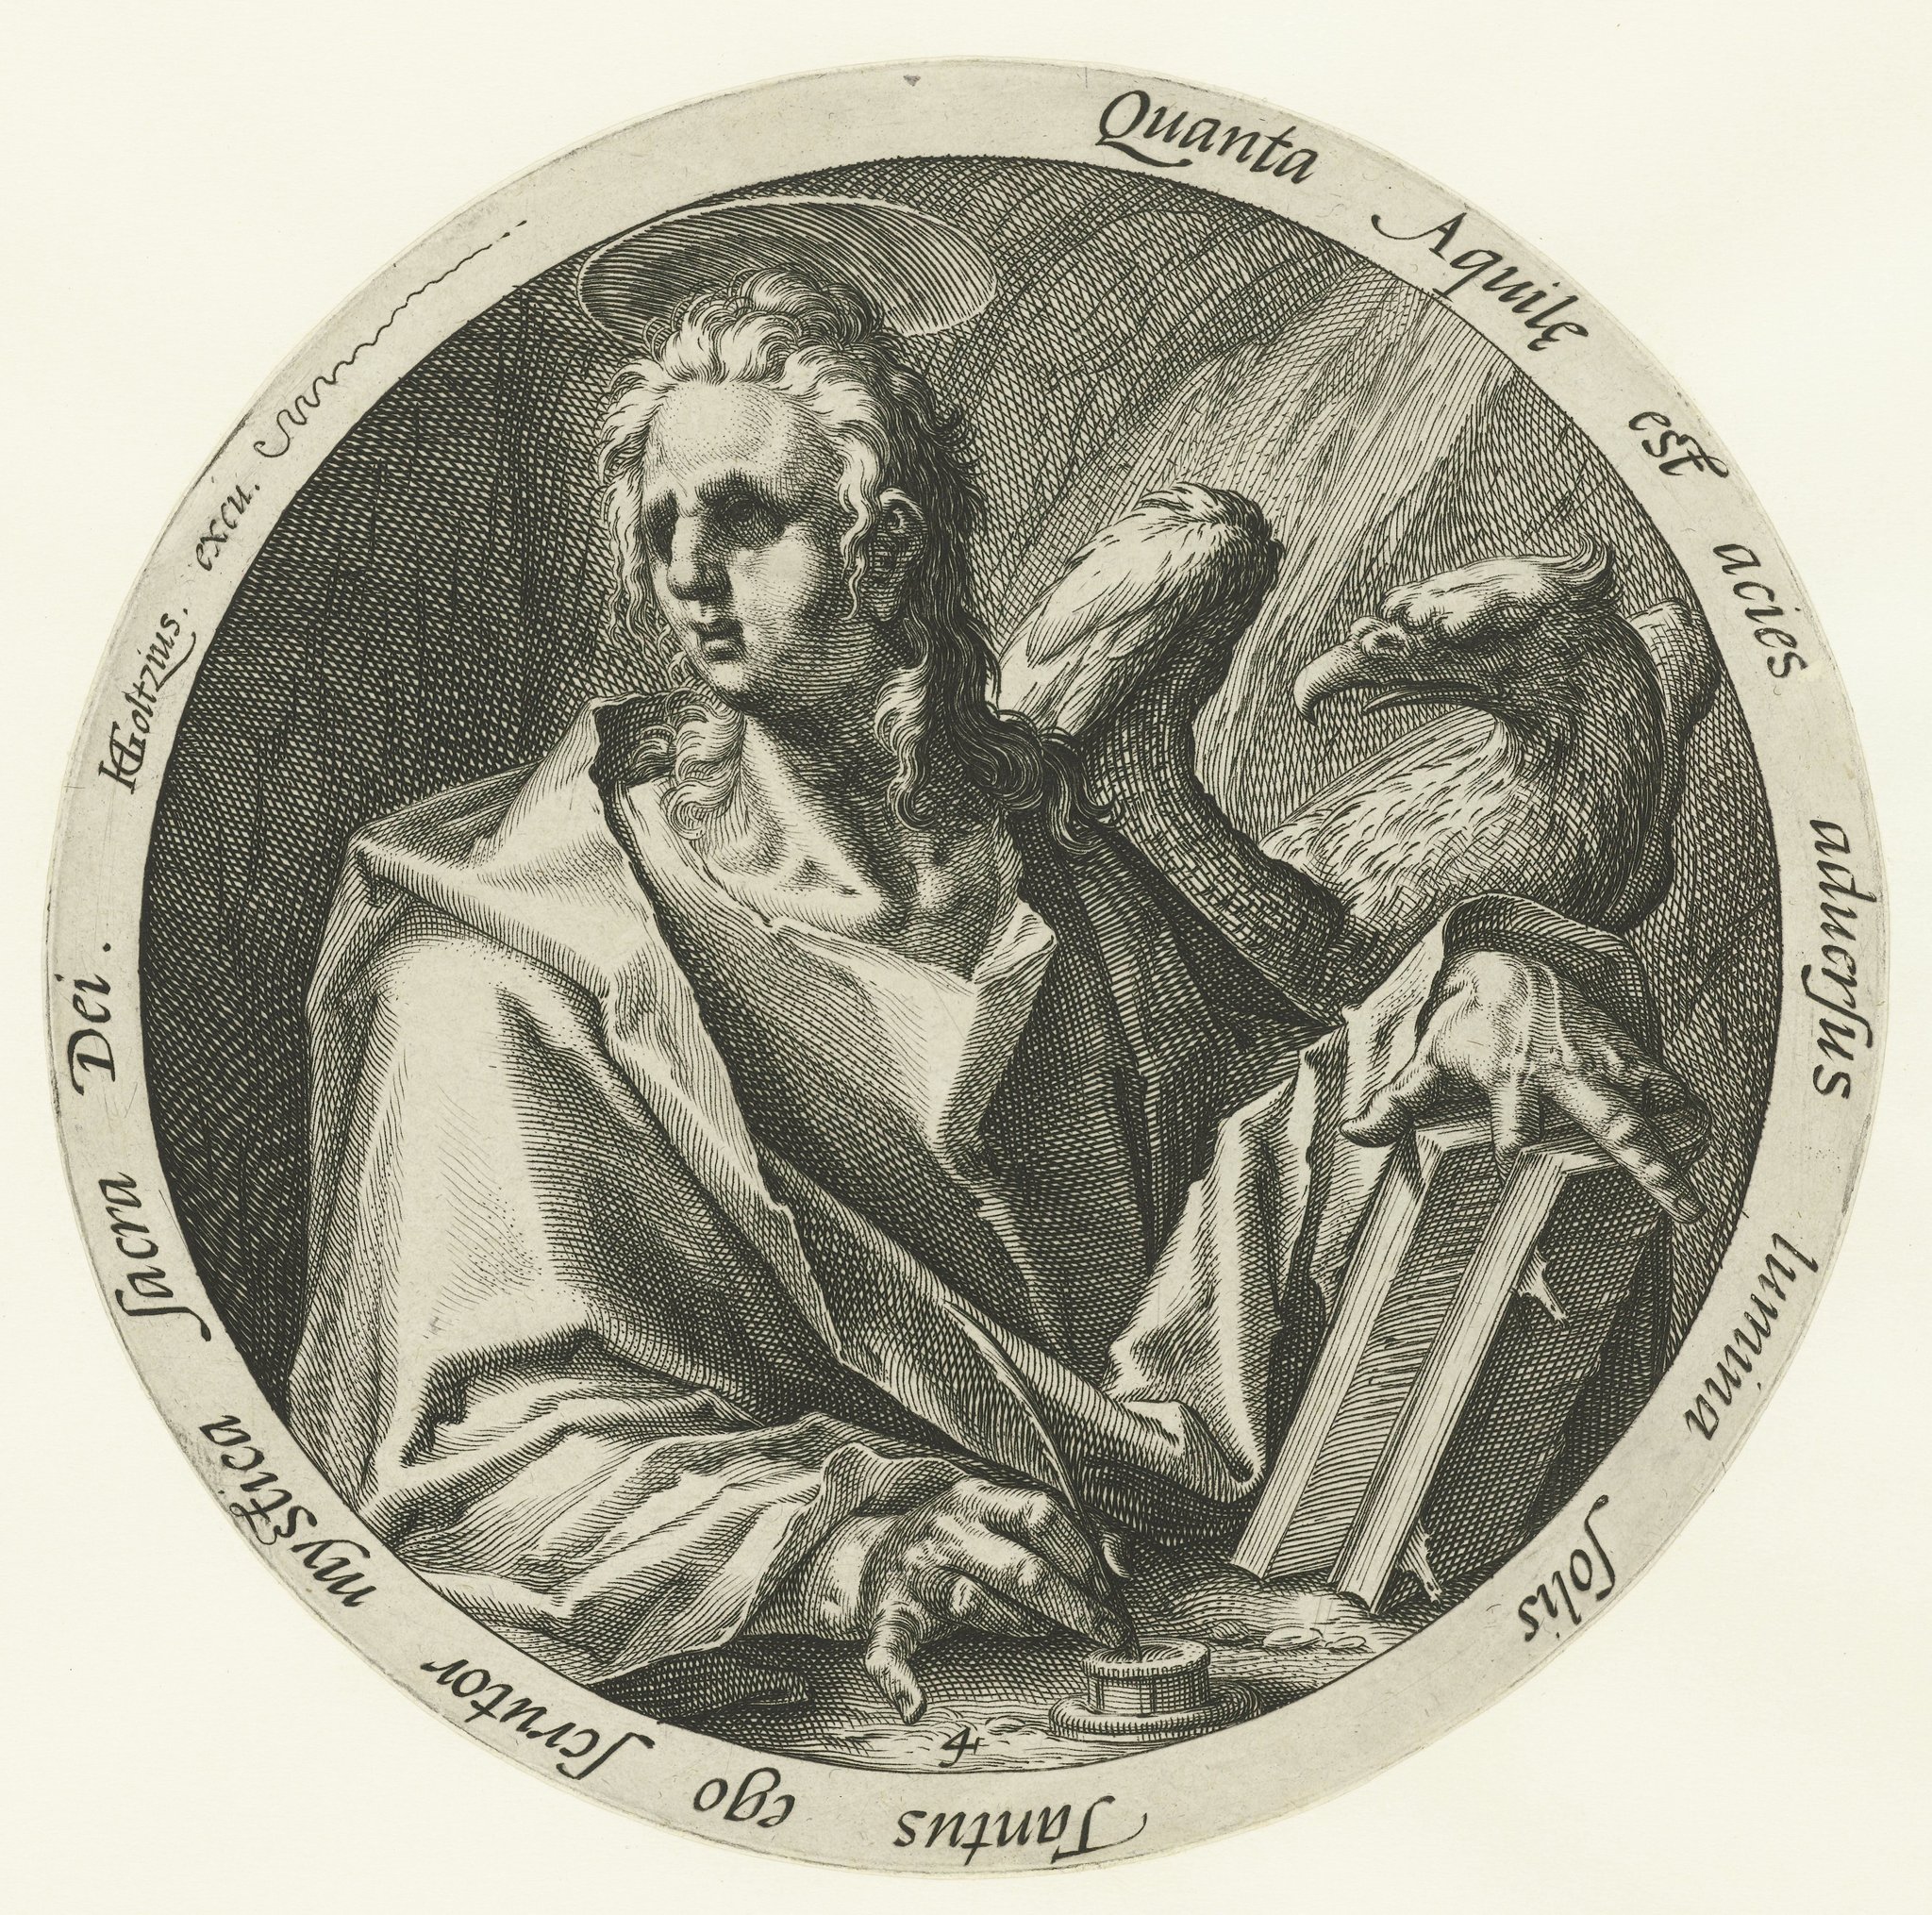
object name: print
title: De vier evangelisten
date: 1588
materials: paper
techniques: engraving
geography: netherlands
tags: the apostle john the evangelist; possible attributes: book, cauldron, chalice with snake, eagle, palm, scroll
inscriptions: collector's mark: Lugt 240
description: Johannes de evangelist, ten halven lijve, die met zijn linkerhand een boek vasthoudt en met zijn rechterhand een pen in een inktpot doopt. Aan zijn linkerzijde staat een adelaar. Om de voorstelling een Latijnse tekst. Deze prent is onderdeel van een serie van vier ronde voorstellingen van de evangelisten, elk omgeven door een witte band waarin een regel Latijn.